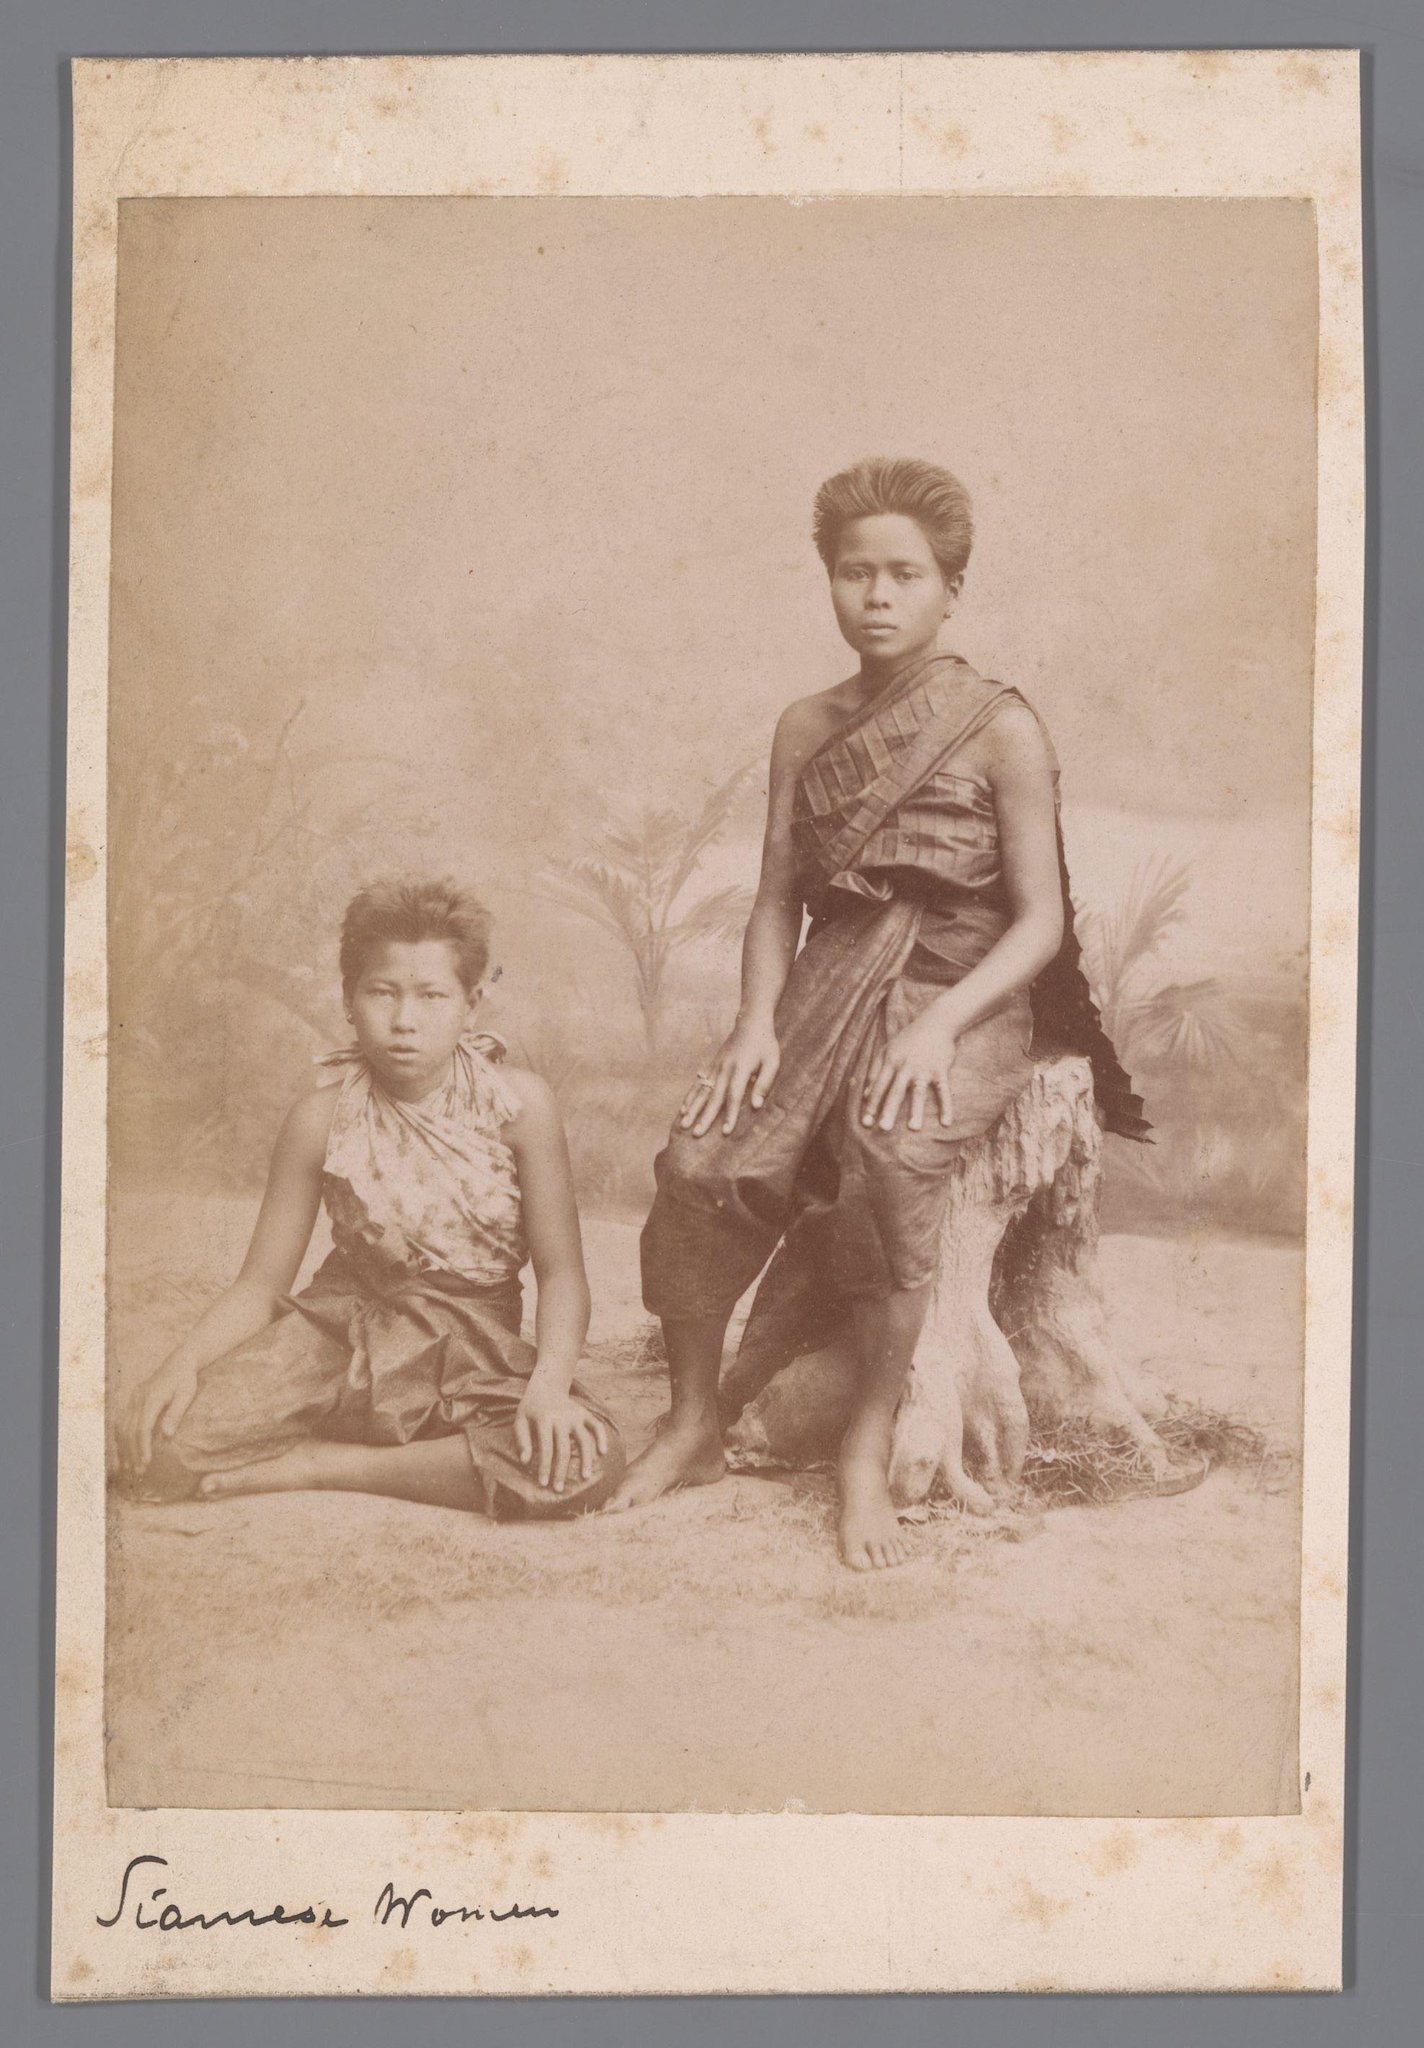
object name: photograph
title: Siamese Women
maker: Anonymous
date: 1860-1900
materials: cardboard, paper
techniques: albumen print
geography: siam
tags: anonymous historical persons portrayed in a double portrait - bb - woman